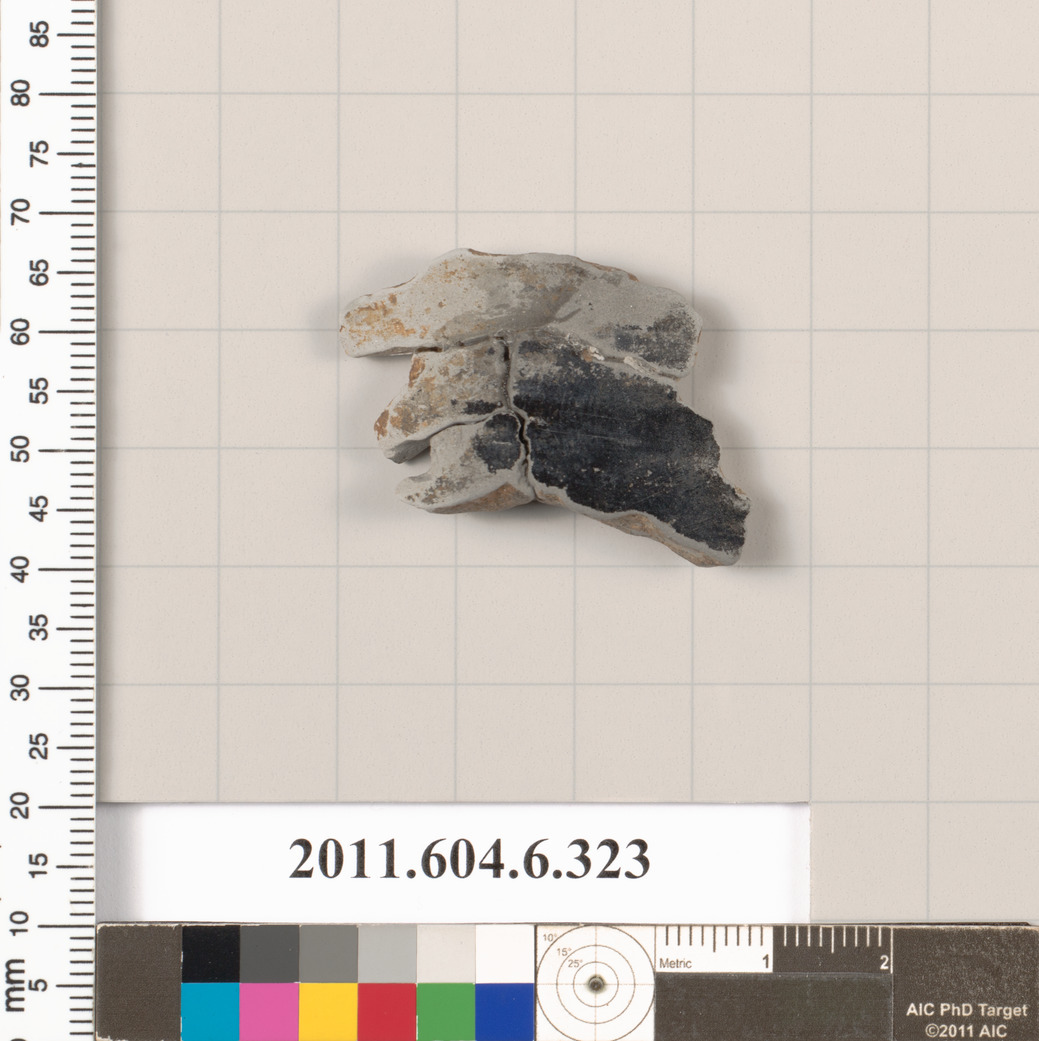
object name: undetermined shape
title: Terracotta fragment of an undetermined shape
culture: greek, attic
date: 600-401 BCE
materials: terracotta